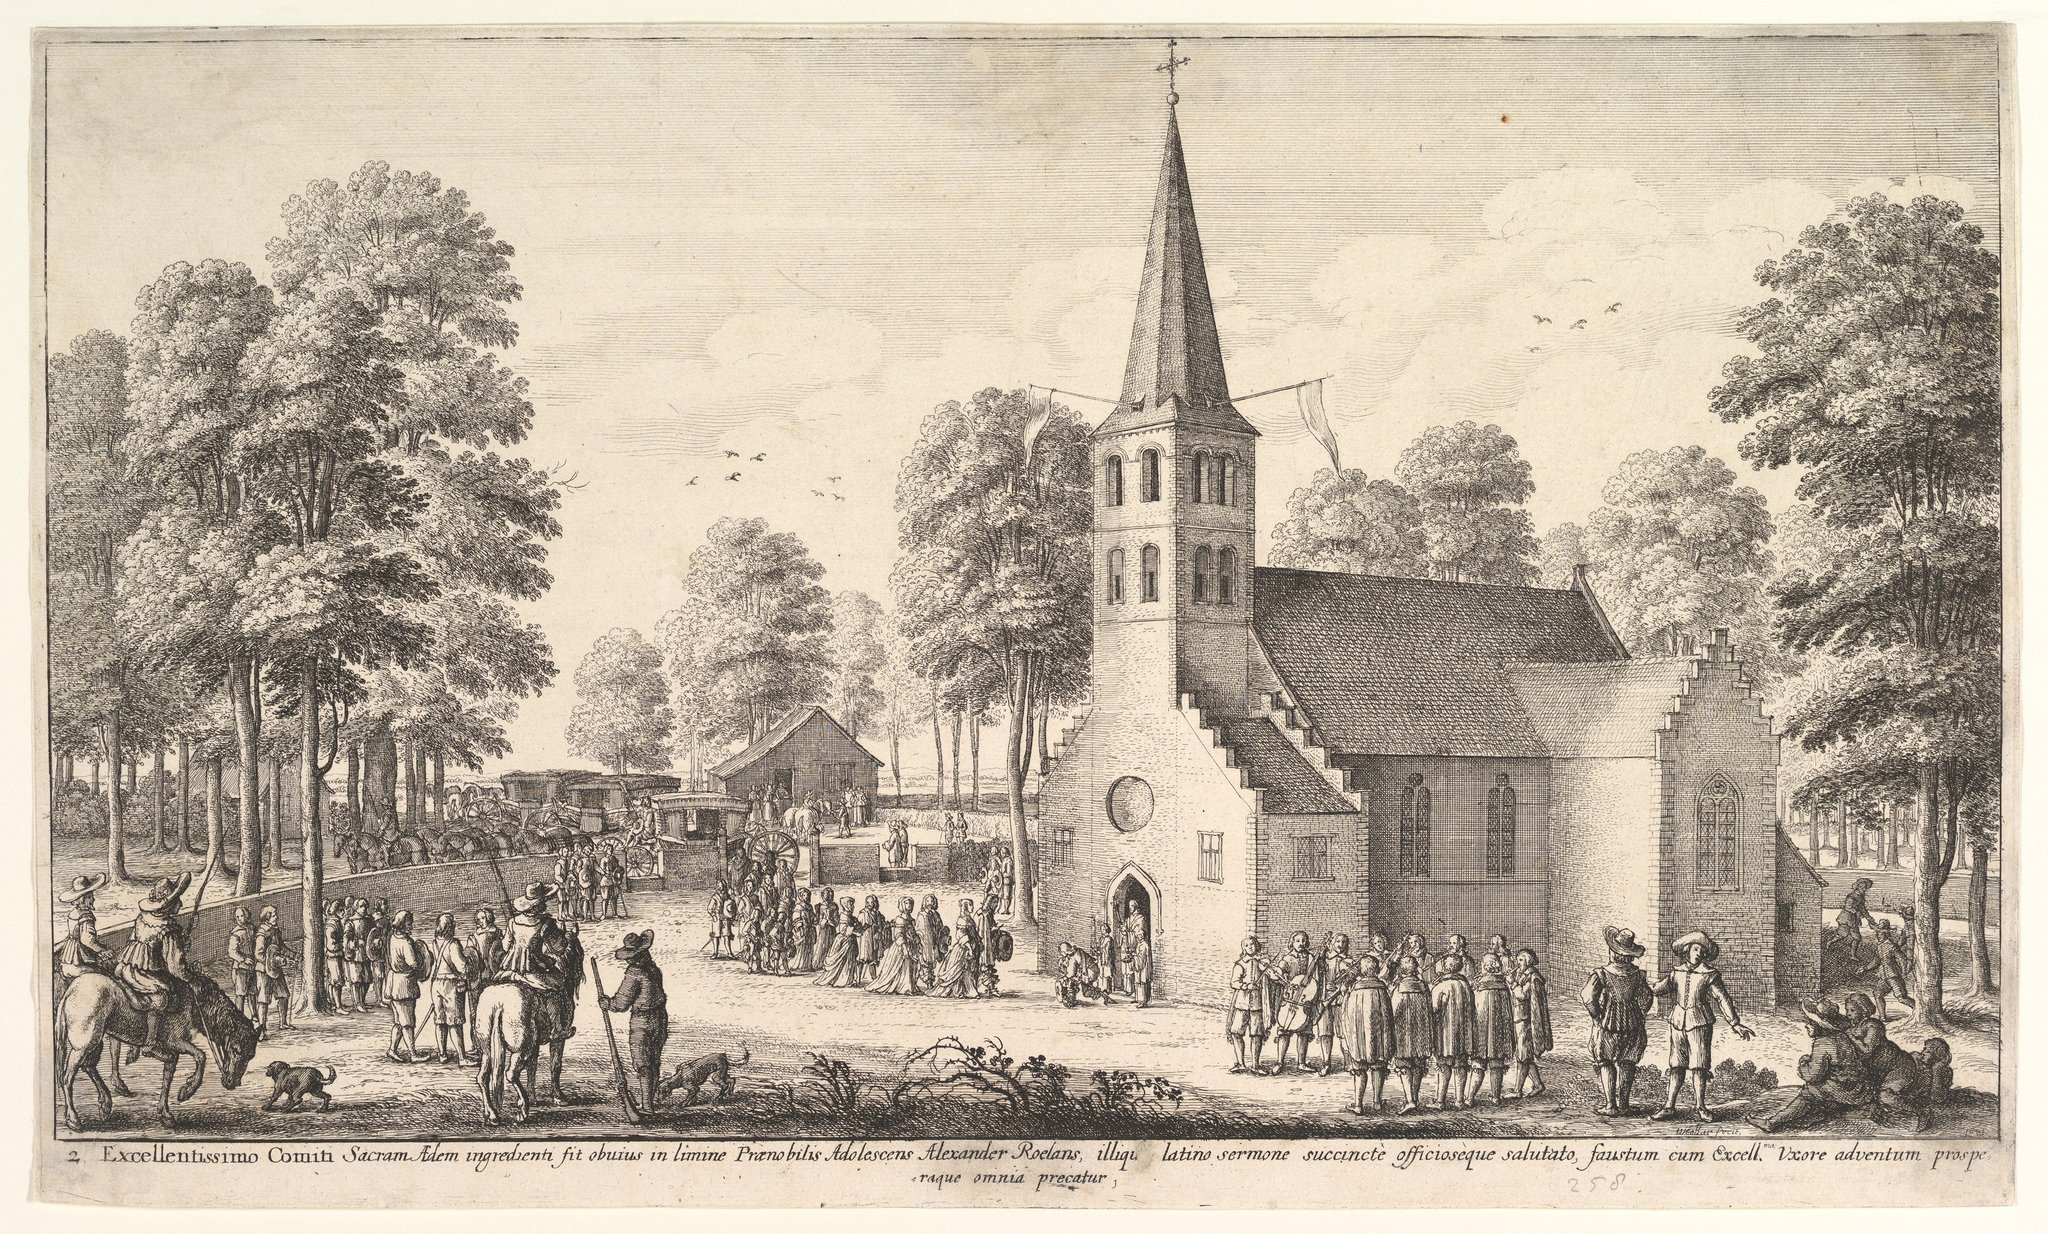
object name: print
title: Going to Church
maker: wenceslaus hollar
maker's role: artist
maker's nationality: bohemian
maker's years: 1607-1677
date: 1651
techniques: etching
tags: churches,men,horses,trees